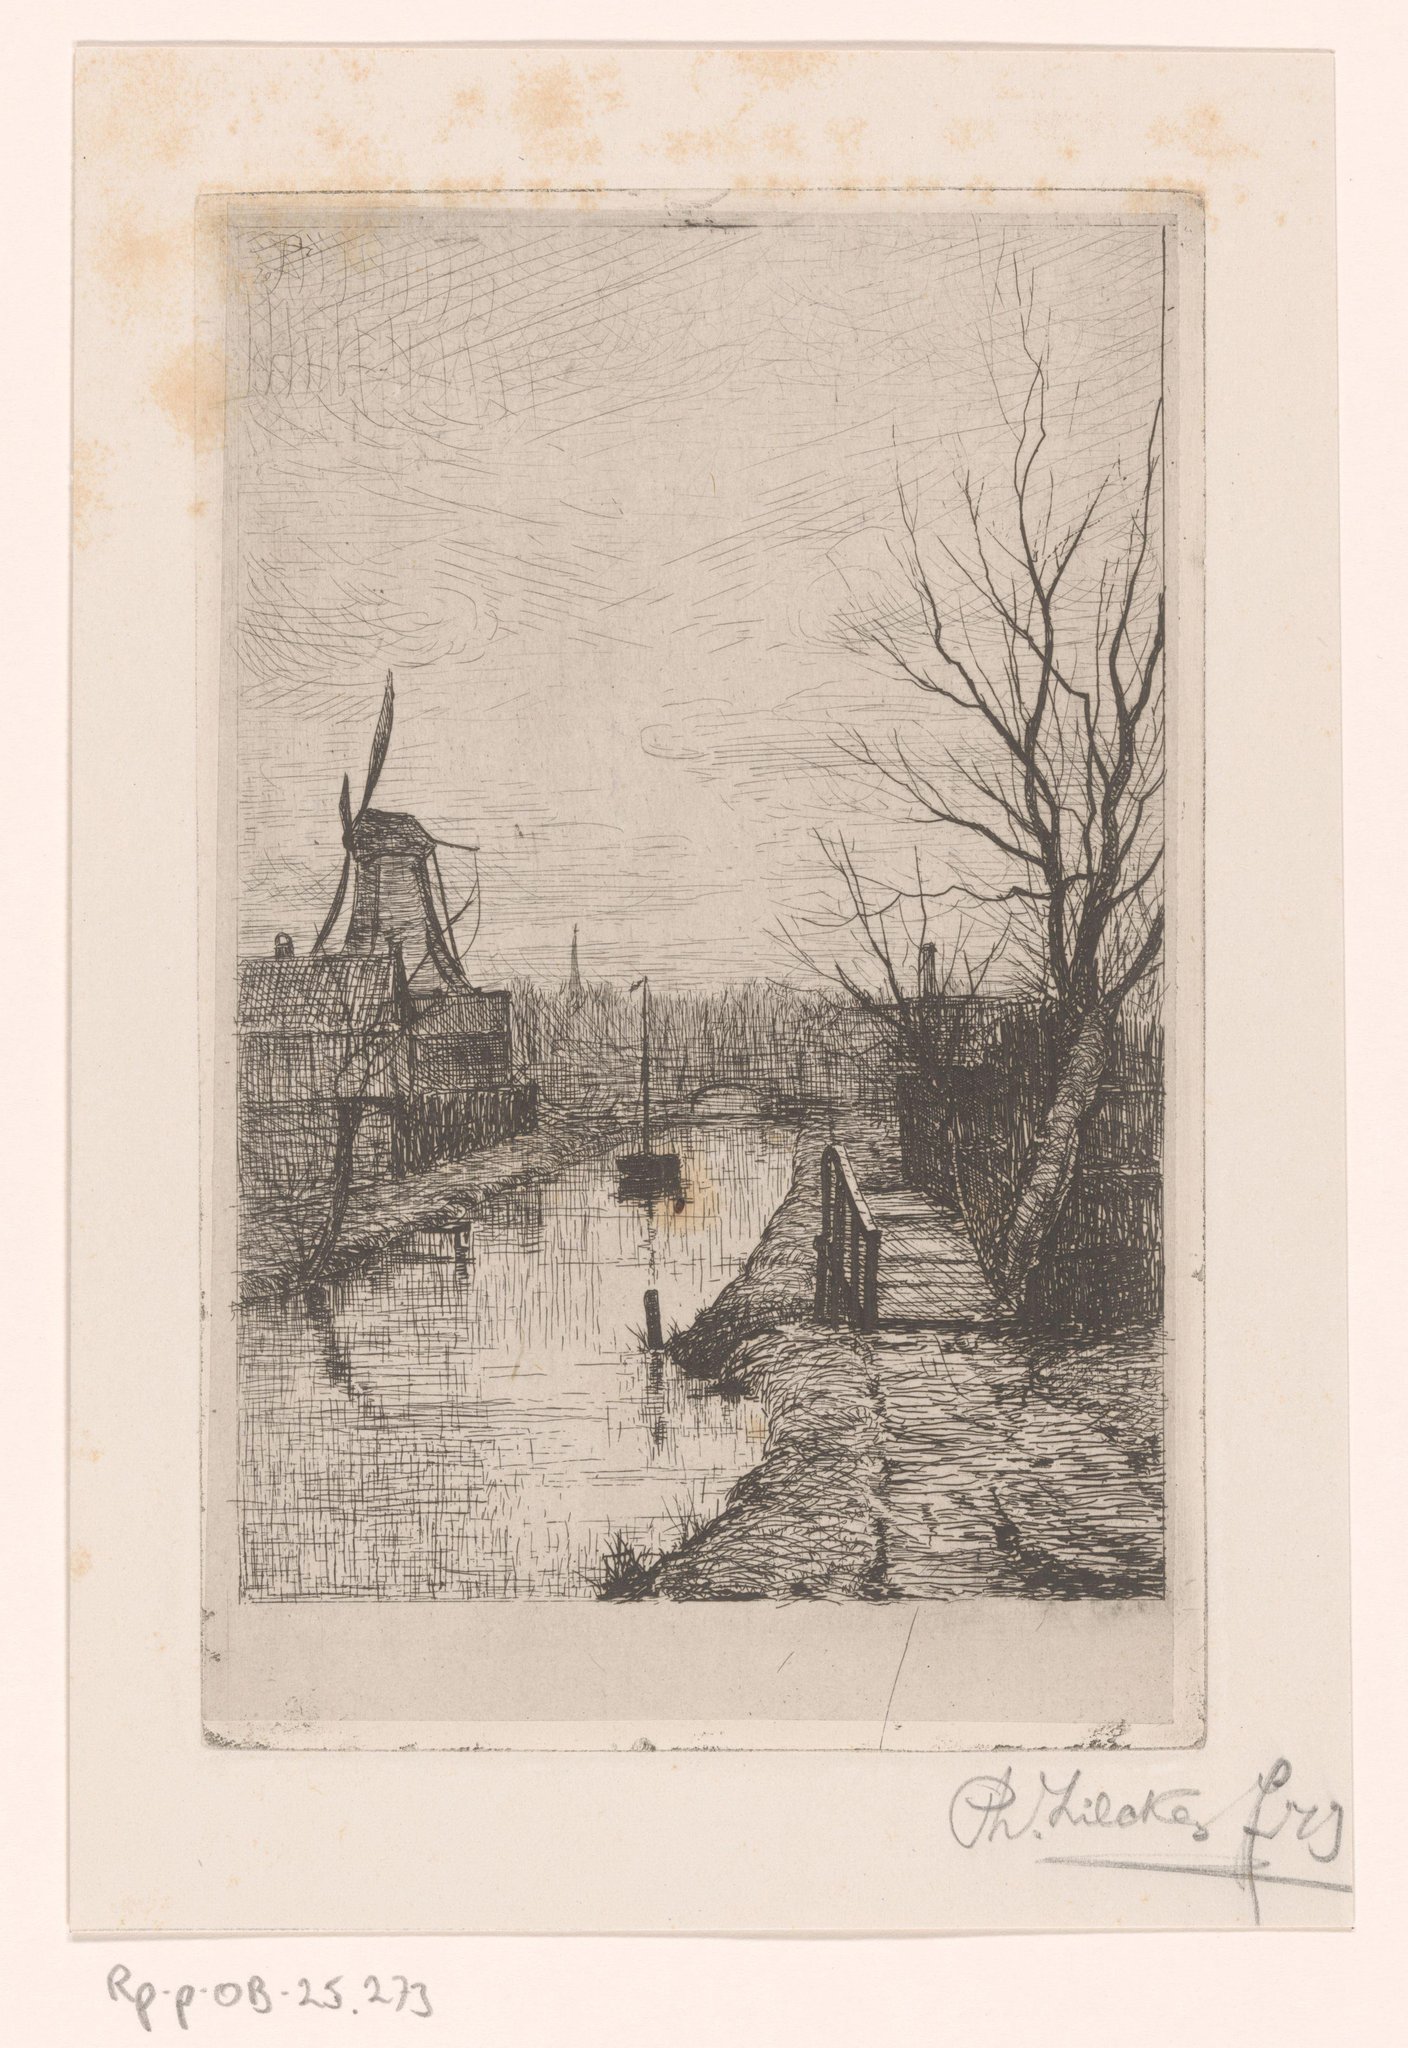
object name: print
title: Passerelle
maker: philip zilcken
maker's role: draughtsman, painter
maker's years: 1857-1930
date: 1879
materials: paper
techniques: etching, intaglio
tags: canal, windmill in landscape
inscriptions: collector's mark: Lugt 2228